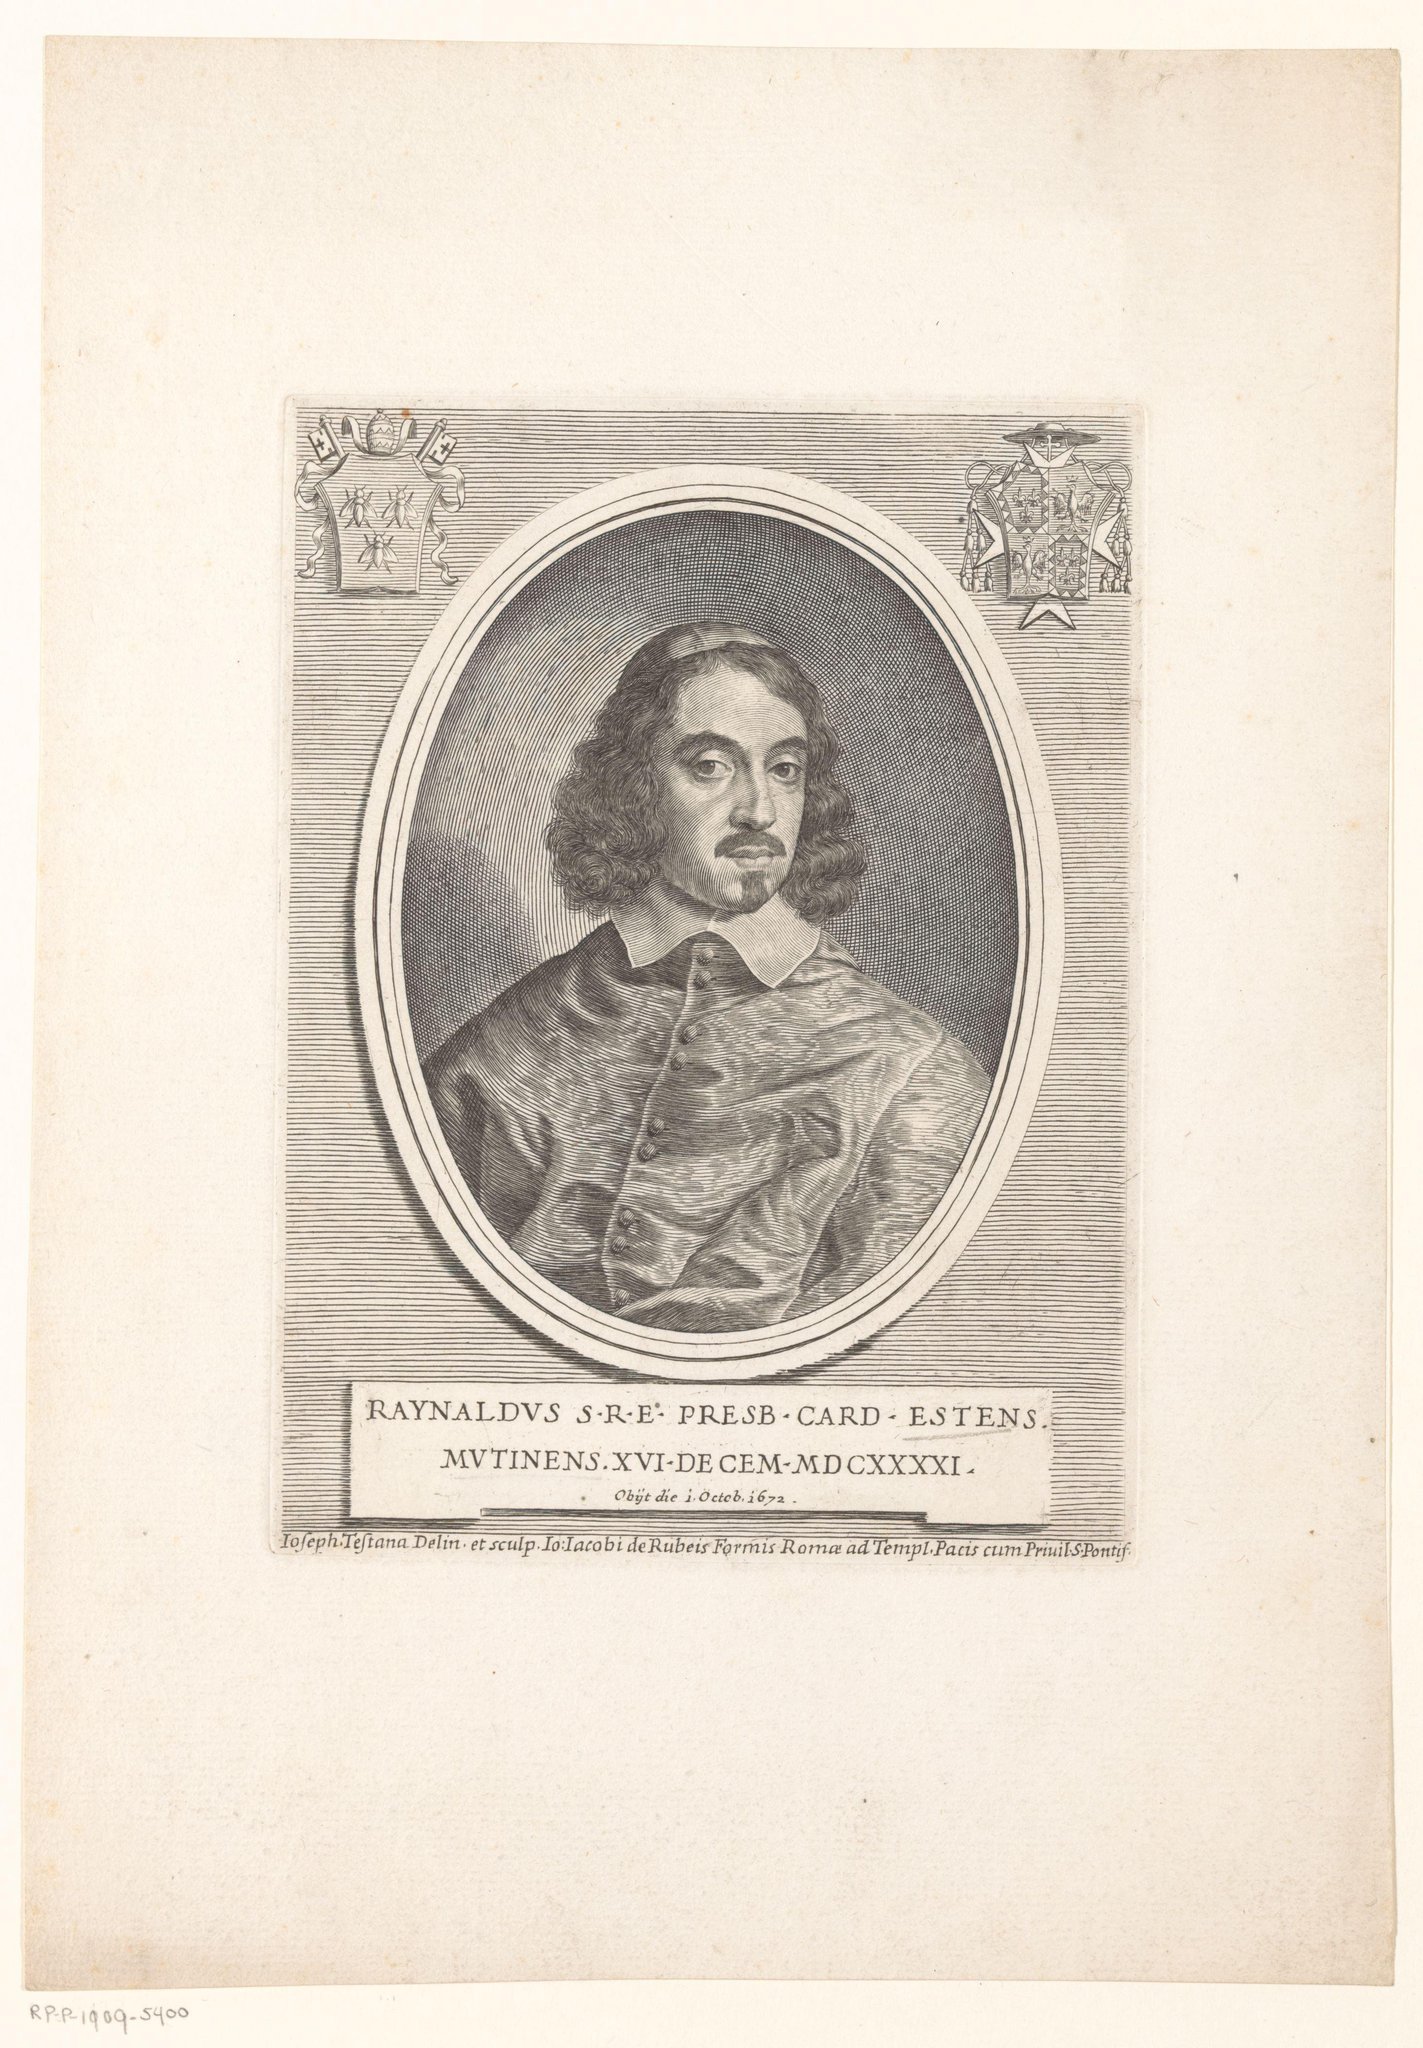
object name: print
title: Portret van kardinaal Rinaldo d'Este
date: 1658-1679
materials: paper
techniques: engraving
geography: italy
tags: cardinal, historical persons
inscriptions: collector's mark: Lugt 2228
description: Prent uit een reeks van onbekende omvang met portretten van kardinalen. De prenten werden vanaf 1657 vervaardigd in opdracht van uitgever Giovanni Giacomo de’ Rossi, waarna de productie werd voortgezet onder leiding van zijn opvolgers Domenico de’ Rossi en Lorenzo Filippo de’ Rossi, en ten slotte onder leiding van de Calcographia R.C.A.